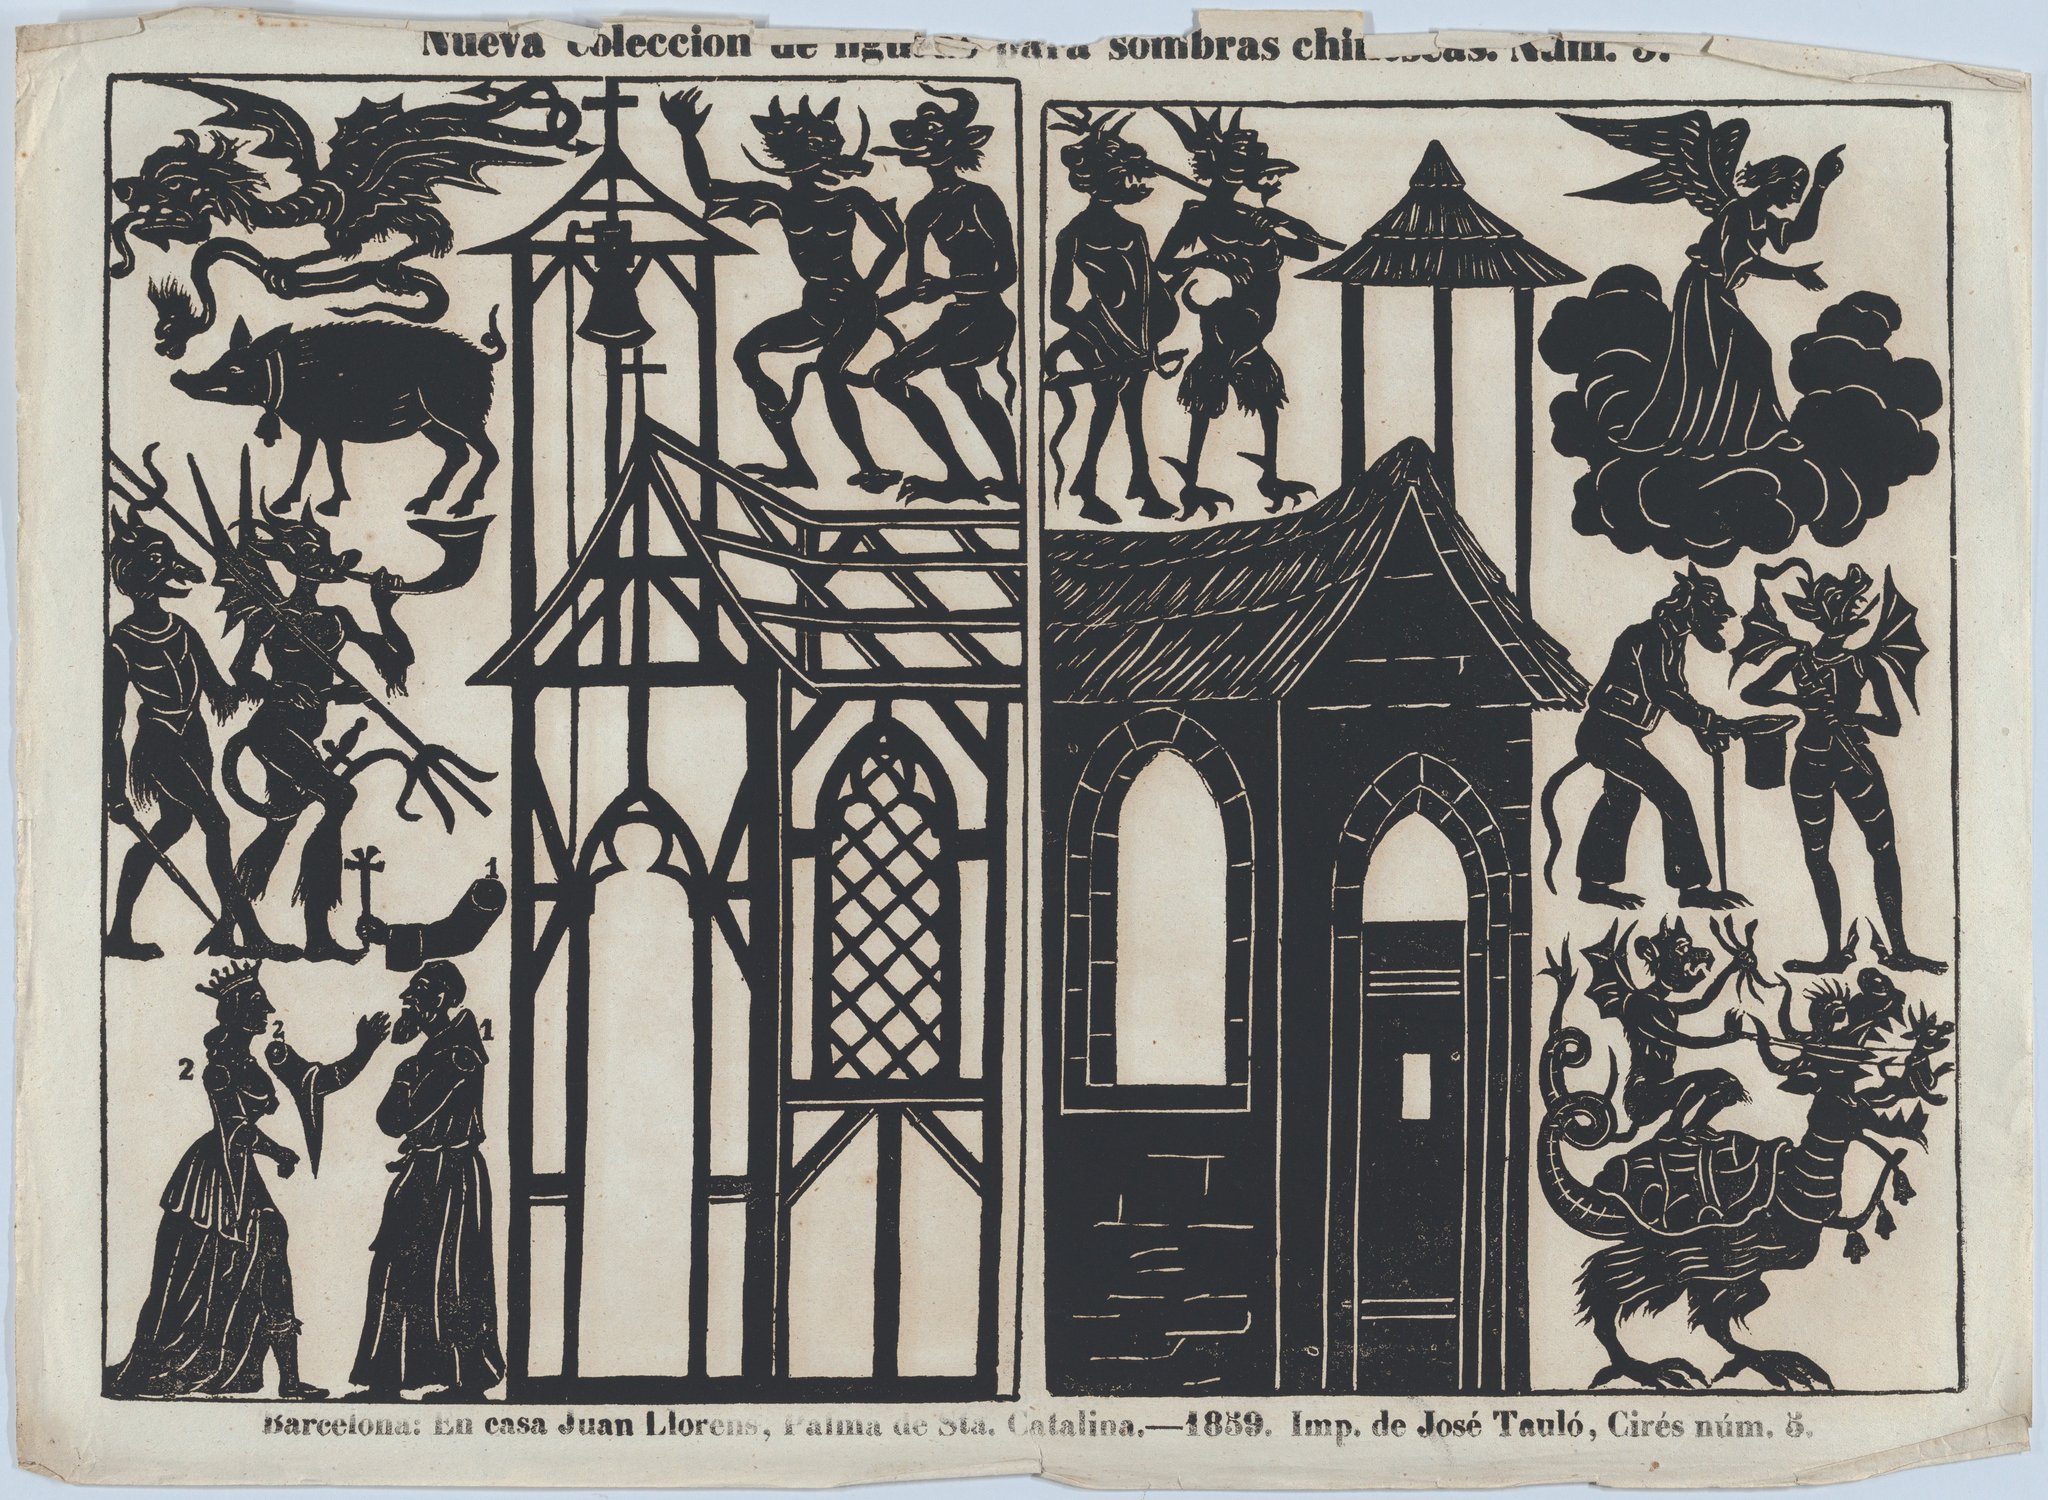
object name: print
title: Sheet 5 of figures for Chinese shadow puppets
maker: juan llorens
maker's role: publisher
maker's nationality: spanish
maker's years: 1800-1900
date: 1859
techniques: engraving, woodcut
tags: boars,angels,devil,puppets